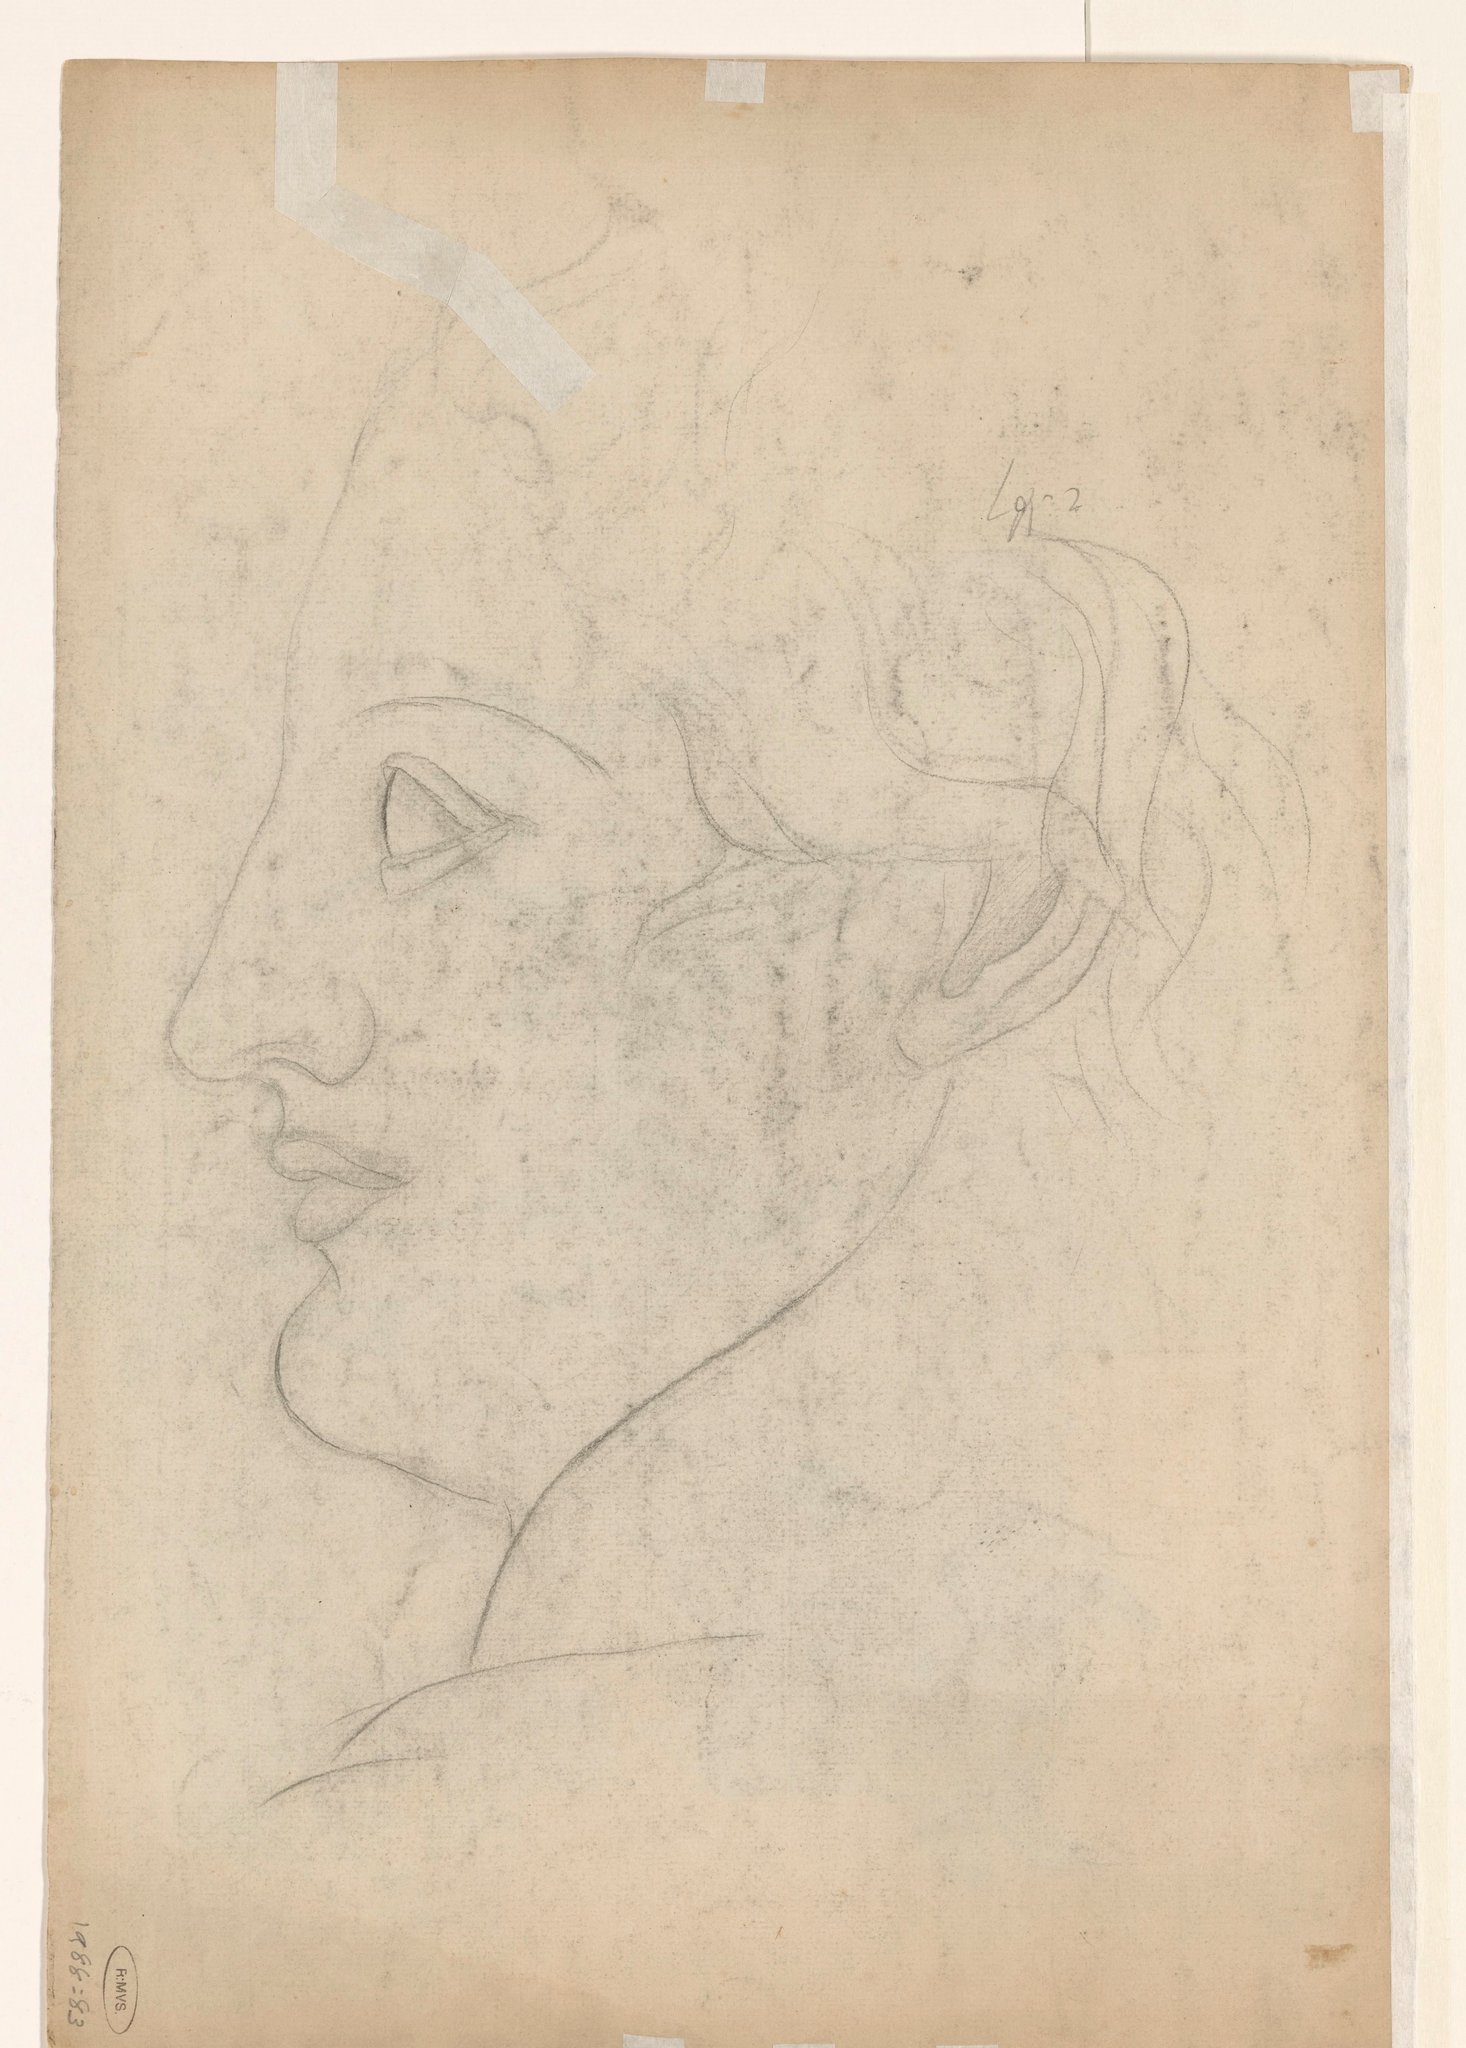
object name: drawing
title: Klassieke kop, naar links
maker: dirk arnoldus tavenraat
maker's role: draughtsman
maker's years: 1845-1930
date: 1855-1930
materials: chalk, paper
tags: piece of sculpture, reproduction of a piece of sculpture